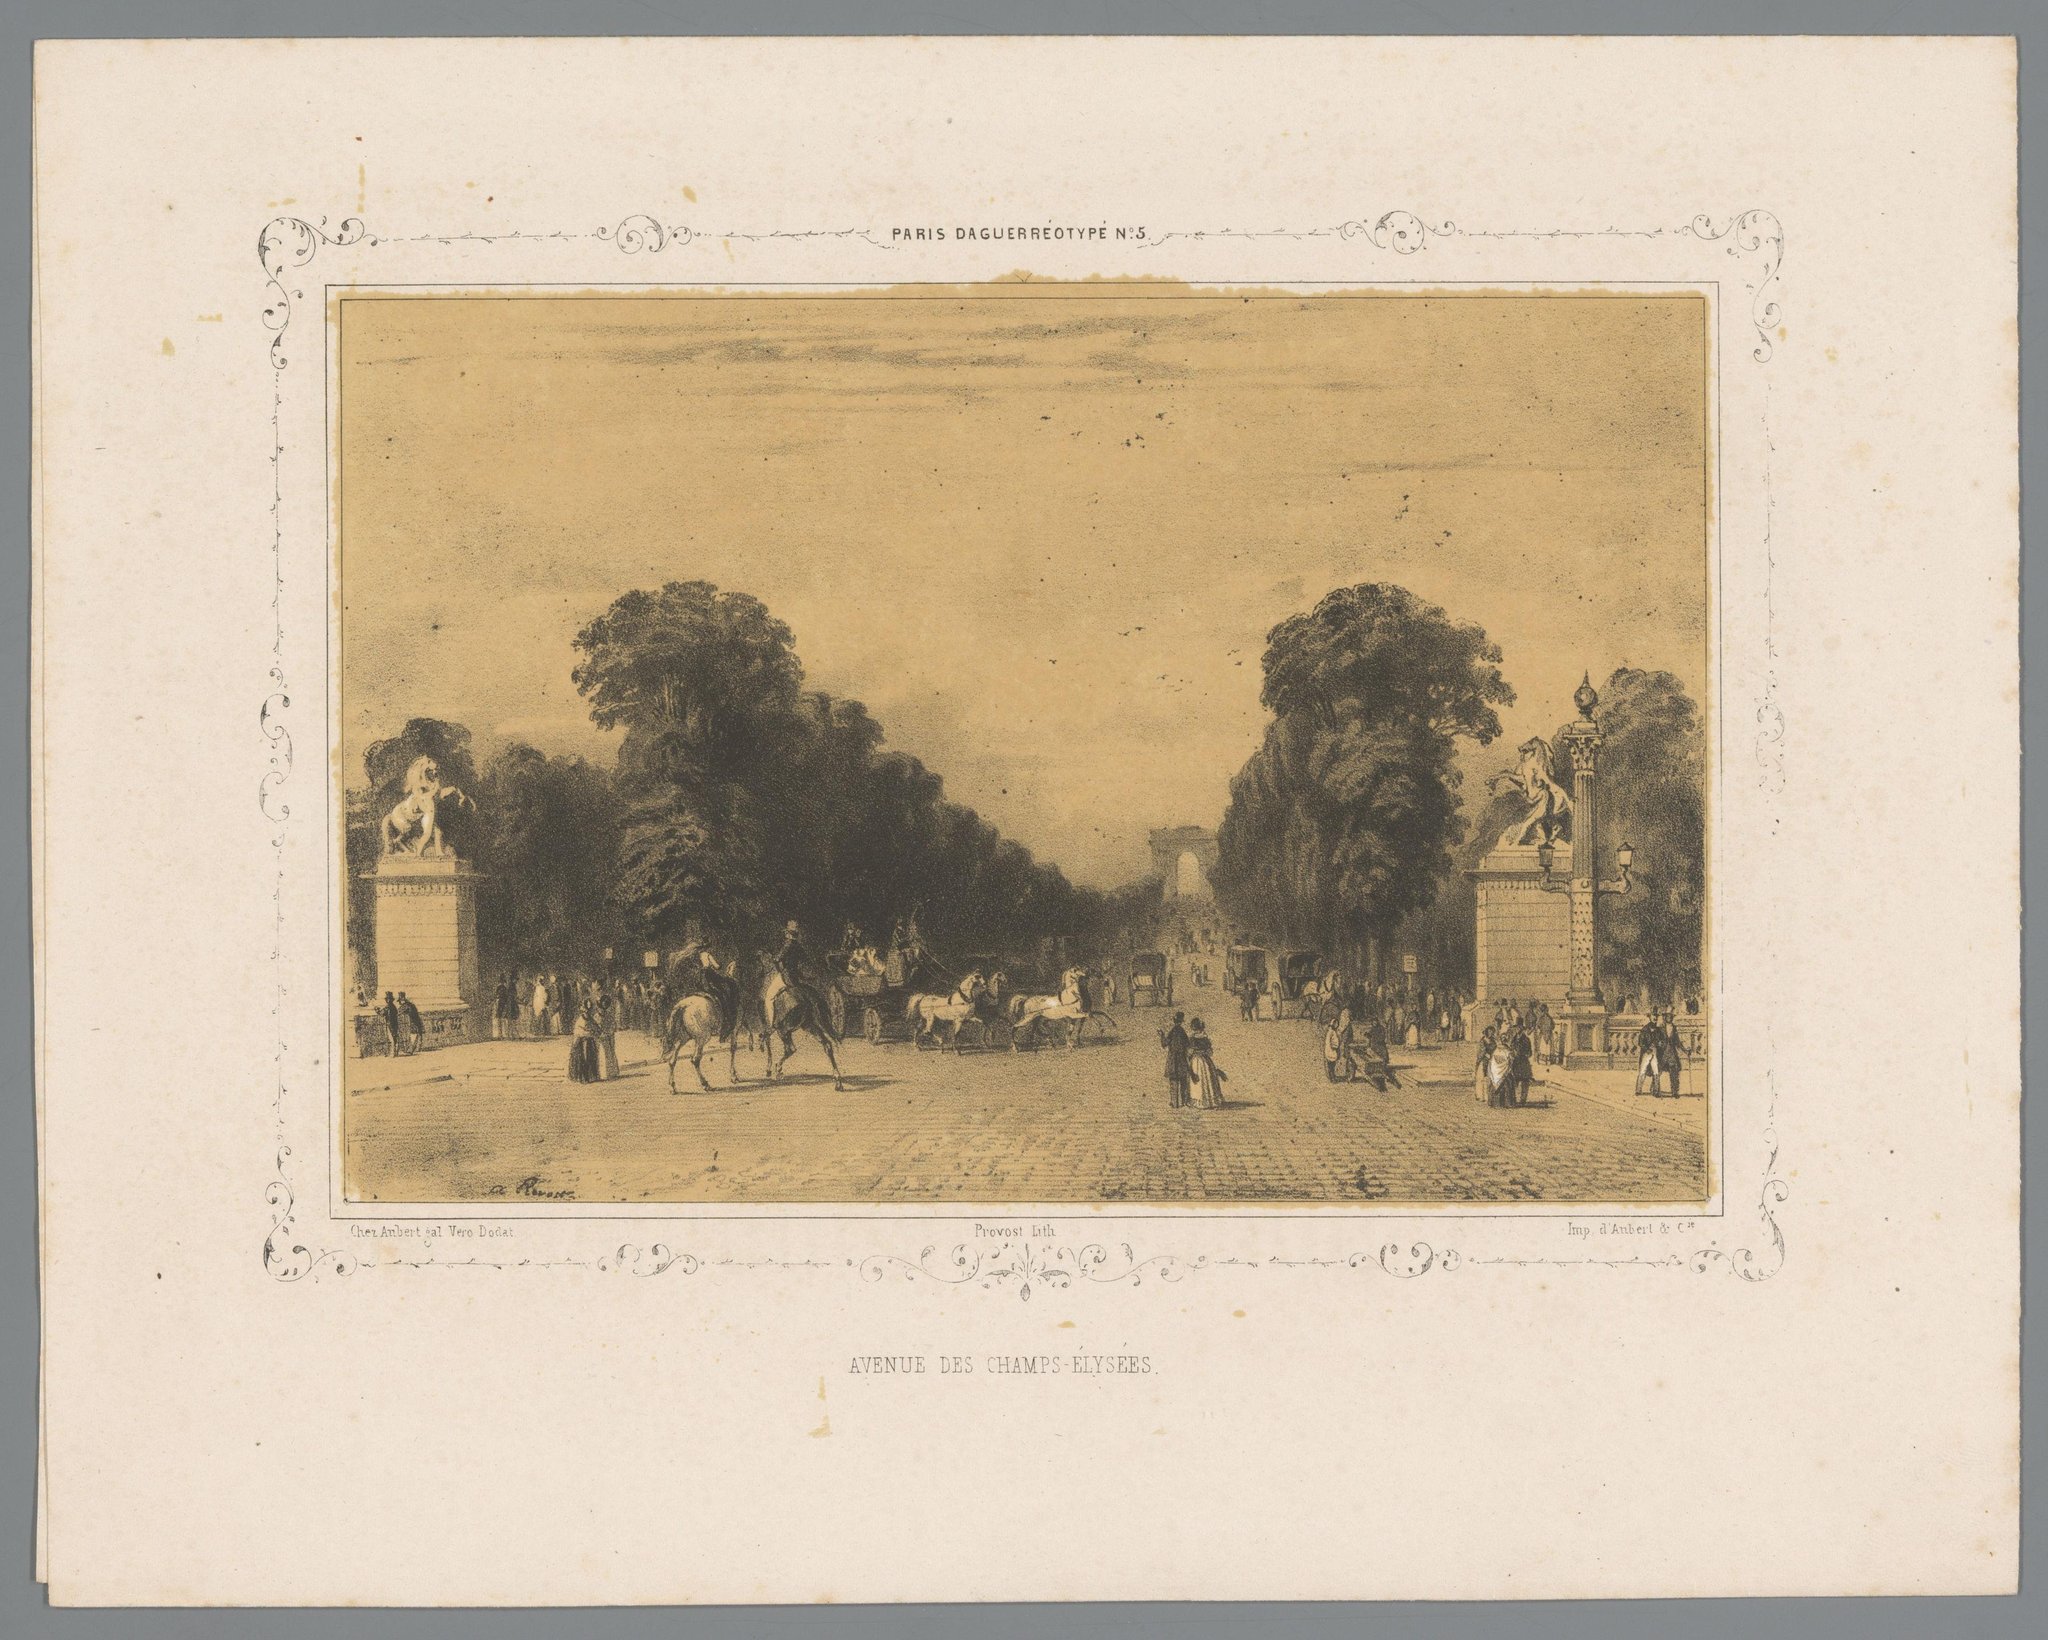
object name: book illustration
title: Avenue des Champs-Élysées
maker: a. provost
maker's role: print maker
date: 1840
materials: paper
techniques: letterpress printing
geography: paris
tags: lane, alley (+ city(-scape) with figures, staffage), paris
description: Prent uit: Philipon, Charles ed. Parys en deszelfs omstreken, voorgesteld door de daguerréotype, onder toezigt van M. Ch. Philipon. Bewerkt naar het Fransch met de oorspronkelyke platen. Amsterdam: Elix & Co., 1840-1842. Deze uitgave is in delen uitgegeven en kon uiteindelijk tot een boek worden ingebonden. Huidige prent behoort tot het eerste deel. Dit is de Nederlandse uitgave van: Philipon, Charles ed. Paris et ses environs reproduits par le daguerréotype, sous la direction de M. Ch. Philipon (…). Parijs: Aubert & Cie, 1840.